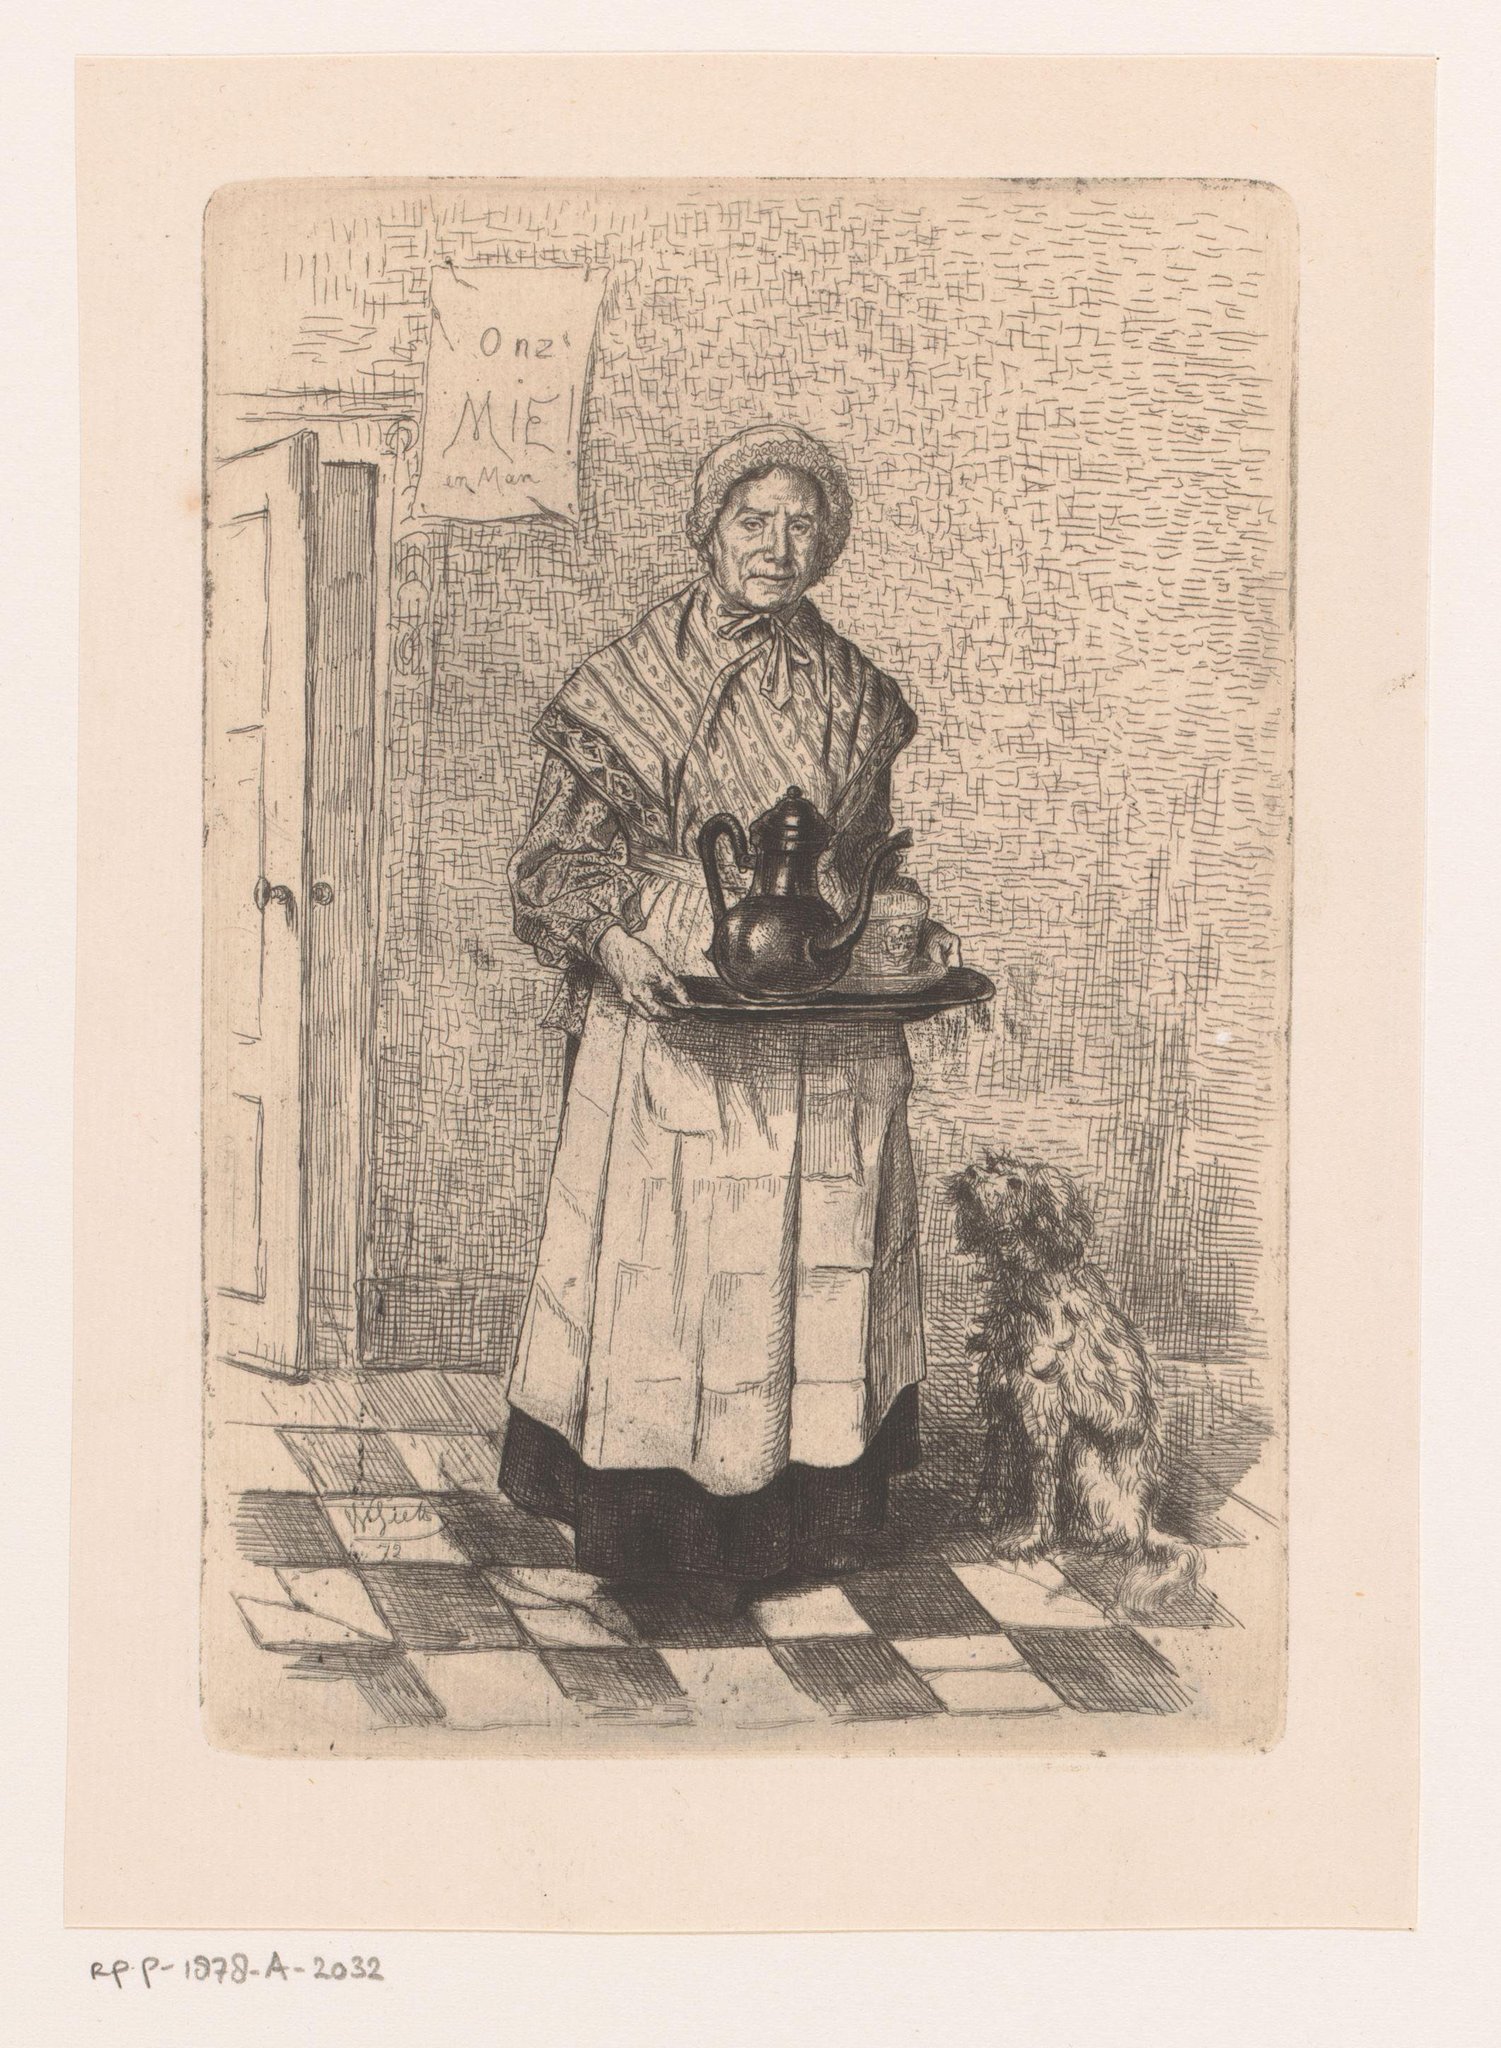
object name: print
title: Oude vrouw met dienblad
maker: willem geets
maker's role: print maker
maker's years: 1838-1919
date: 1872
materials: paper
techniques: etching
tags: old woman, salver, dog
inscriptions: collector's mark: Lugt 2228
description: Prent uit: Bergmann, Anton. Ernest Staas, advocaat: schetsen en beelden. Gent: Hoste, Den Haag: Martinus Nijhoff, [1874-1875].